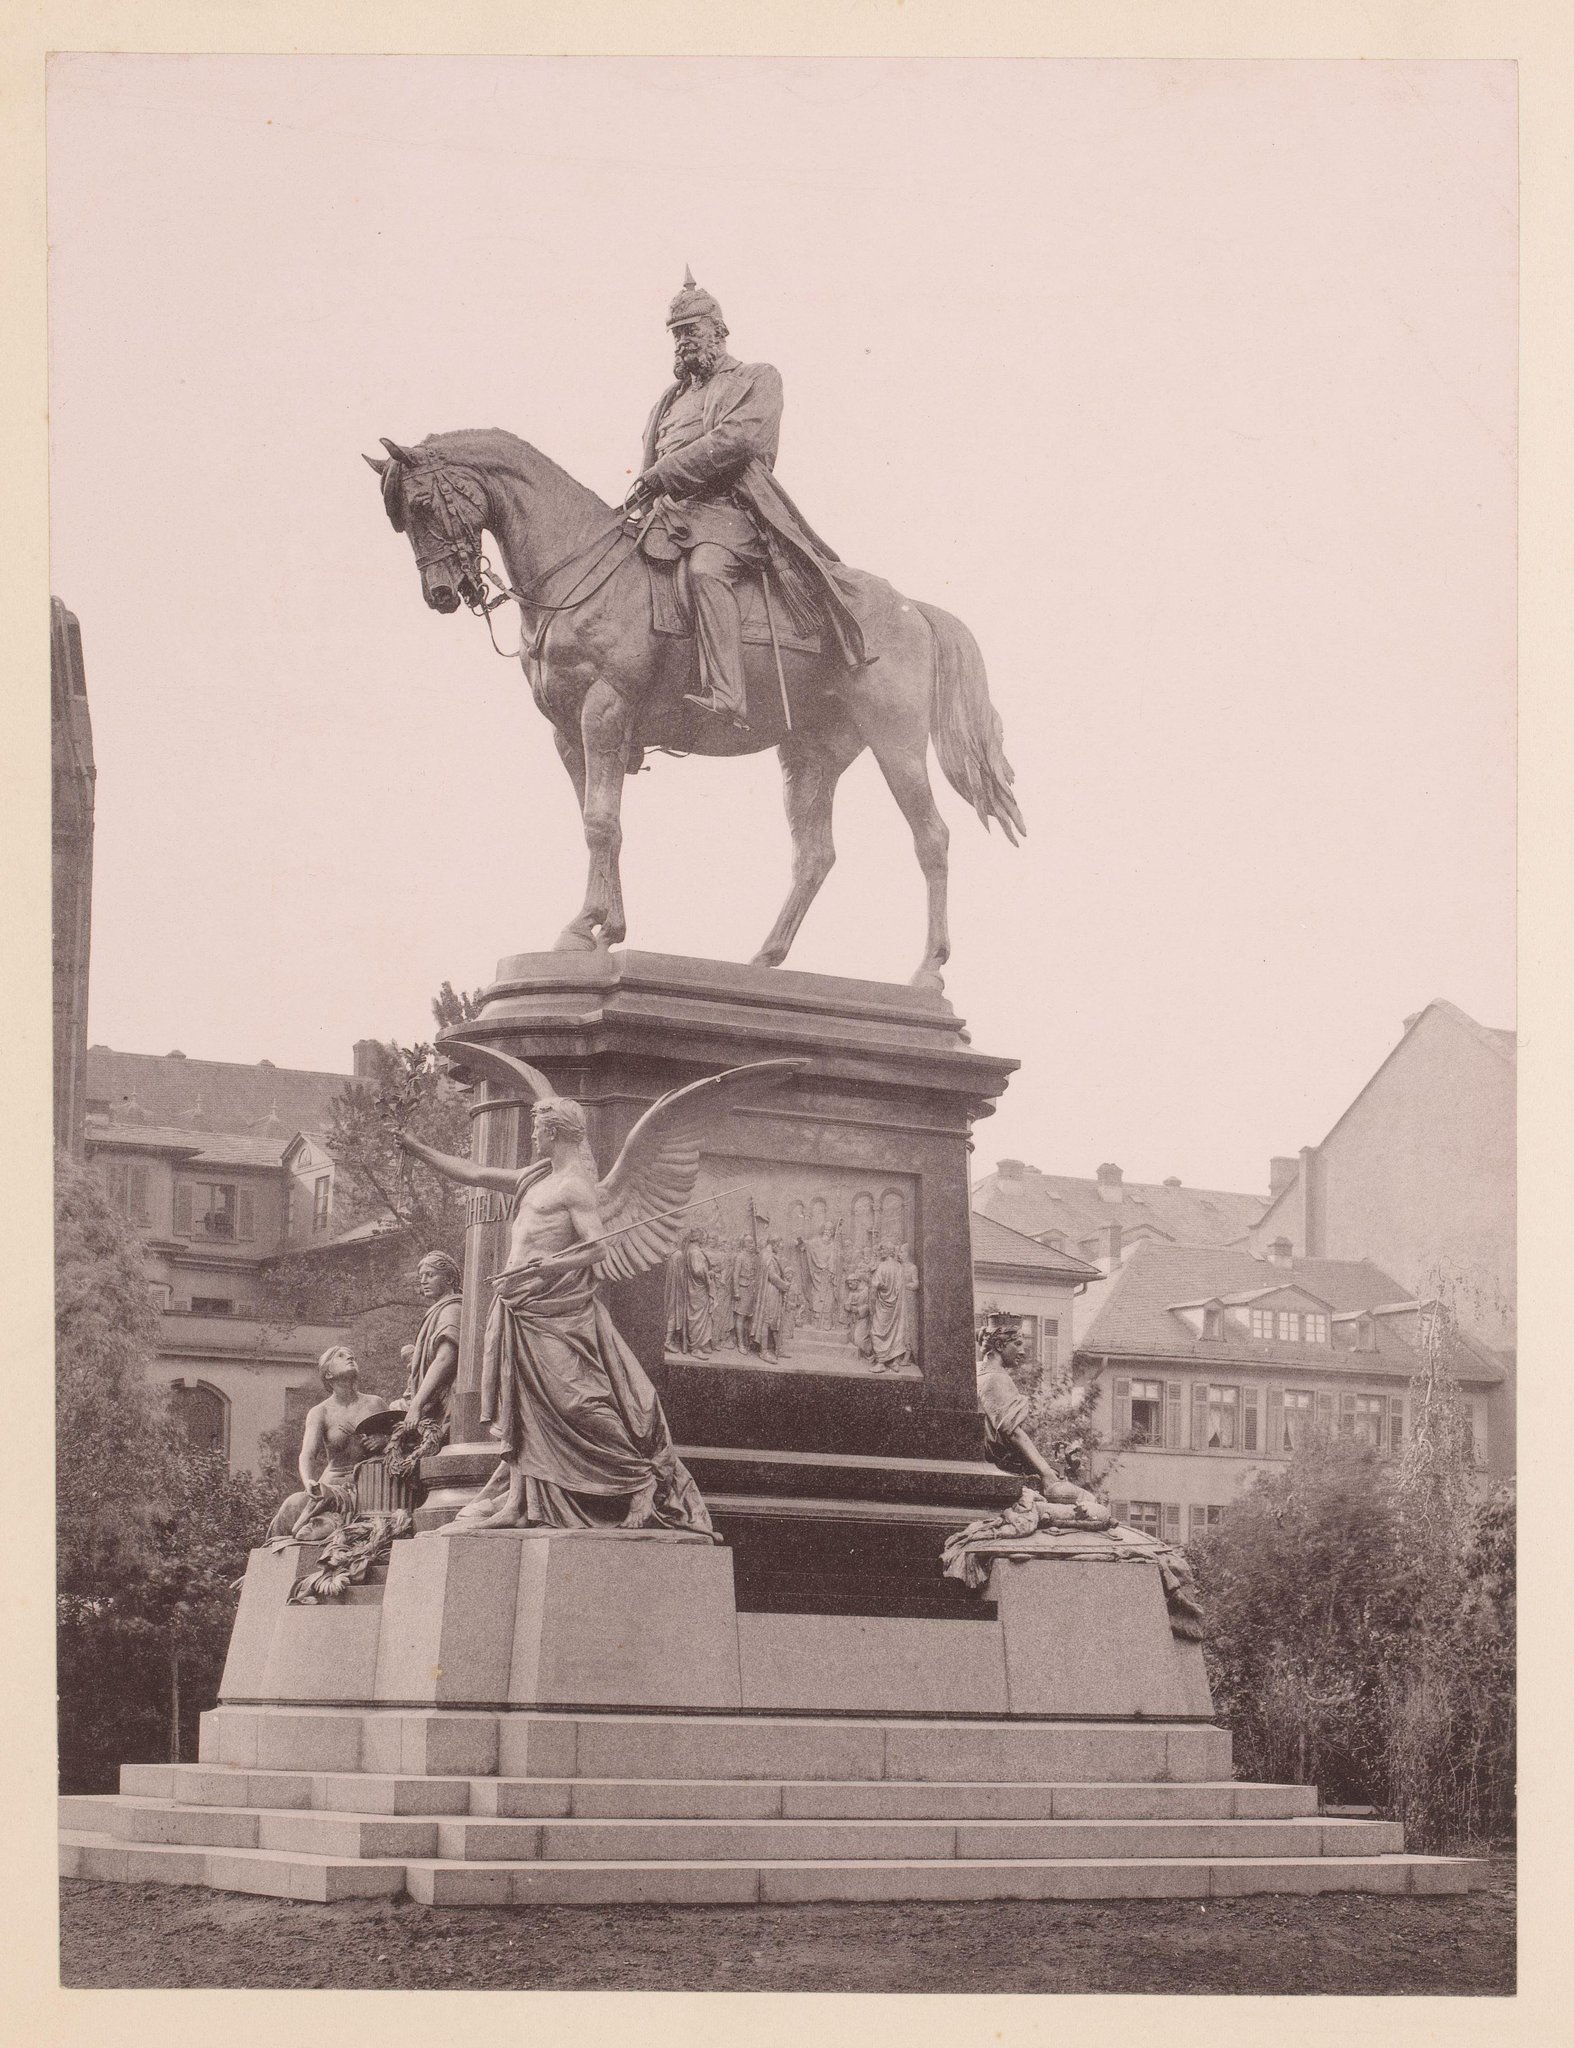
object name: photograph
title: Ruiterstandbeeld op sokkel van keizer Wilhelm I, Frankfurt-am-Main, Duitsland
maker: Anonymous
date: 1875-1900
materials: cardboard, photographic support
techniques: photograph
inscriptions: caption: ‘Station Frankfurt’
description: Ruiterstandbeeld op sokkel van keizer Wilhelm I, Frankfurt-am-Main, Duitsland. Beeldhouwer was Clemens Buscher (1855–1916), die het standbeeld in 1896 maakte. In WO II werd het vernietigd en omgesmolten.